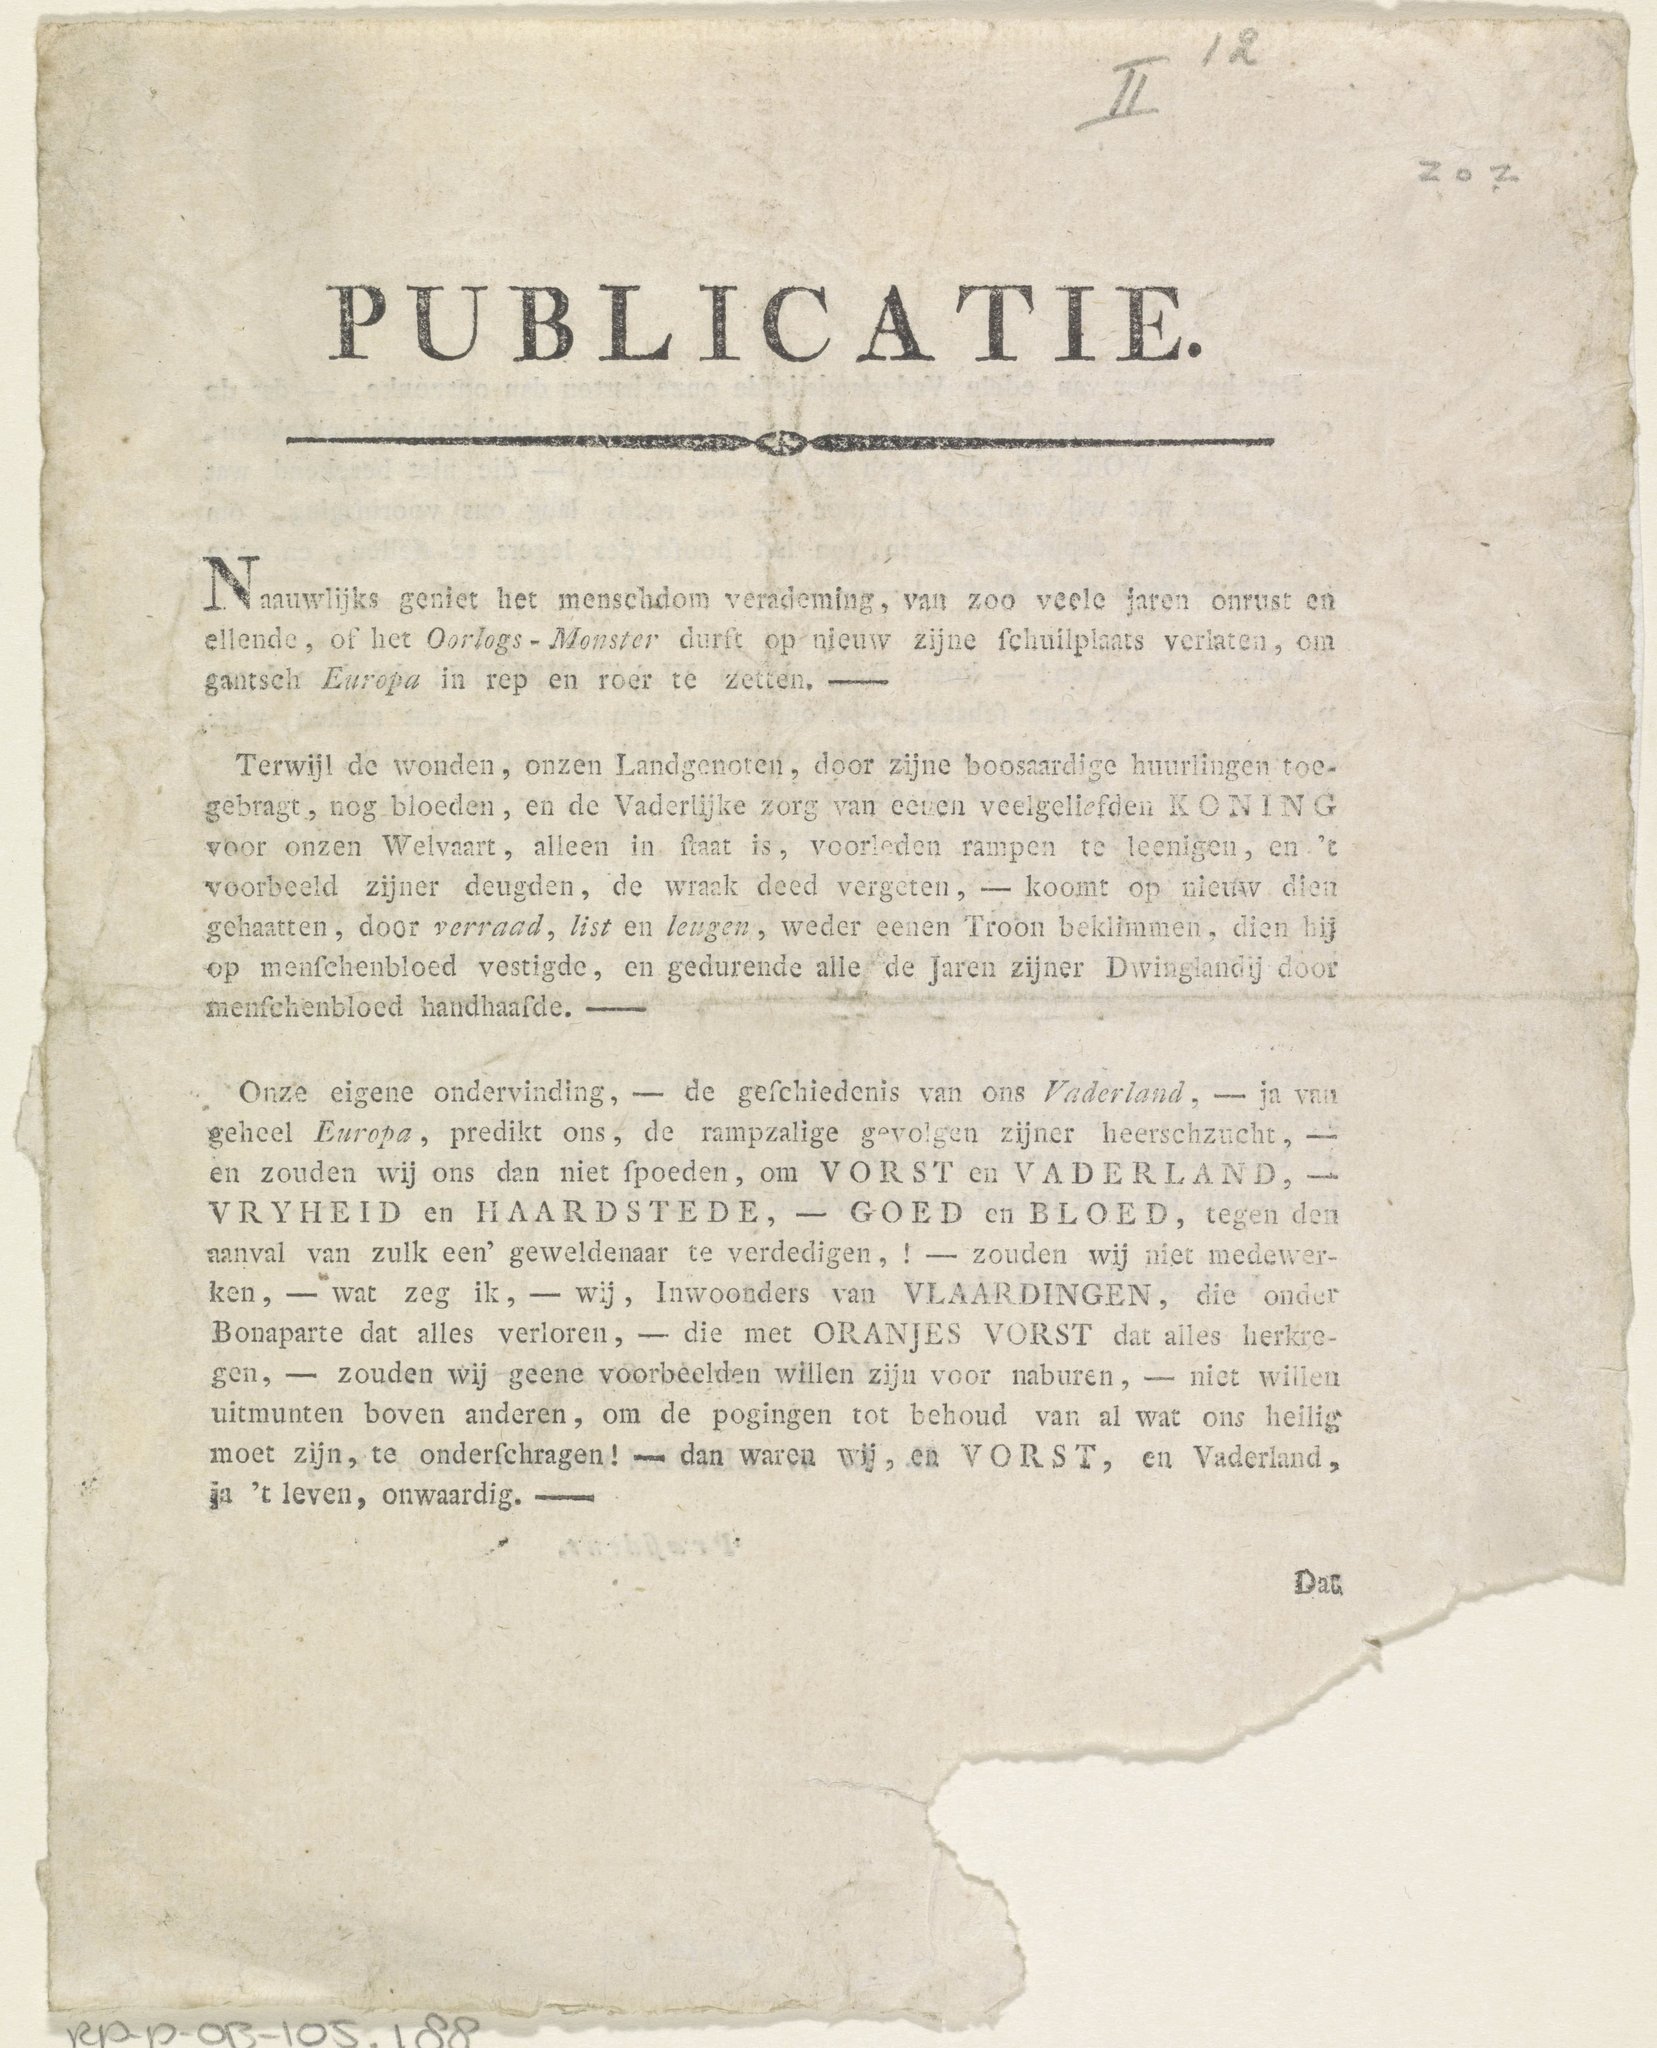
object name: text sheet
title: Oproep om te strijden in het leger van Willem I Frederik, koning der Nederlanden, door het bestuur van de stad Vlaardingen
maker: hendrik luidwijn van linden van den heuvell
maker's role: mayor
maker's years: 1785-1854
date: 1815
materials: paper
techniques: letterpress printing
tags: the hague, berlin, william i of the netherlands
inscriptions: date